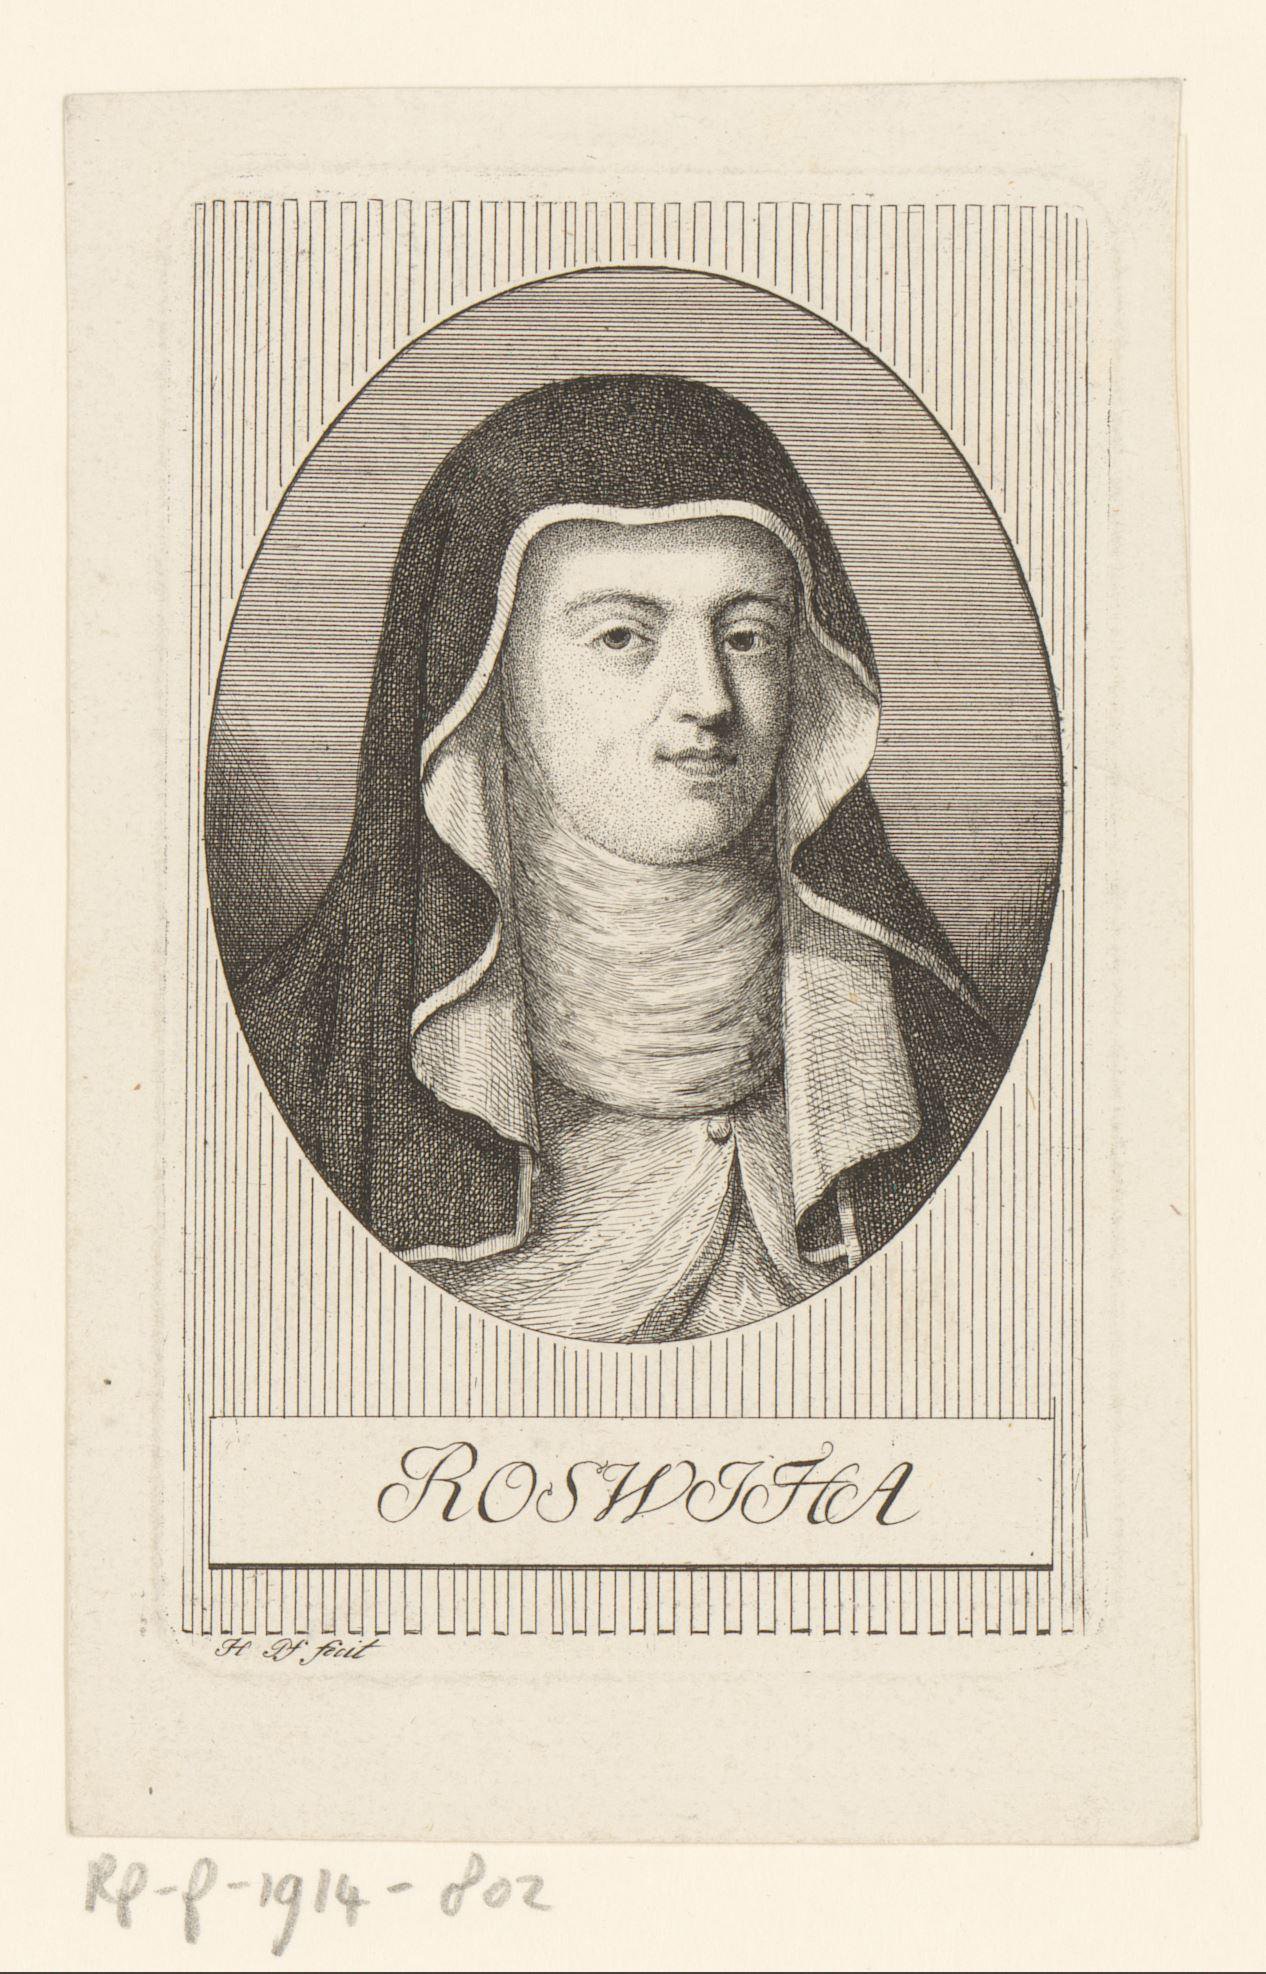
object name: print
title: Portret van Roswitha van Gandersheim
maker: heinrich pfenninger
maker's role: print maker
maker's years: 1749-1815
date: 1759-1815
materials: paper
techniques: etching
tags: historical persons - bb - woman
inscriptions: collector's mark: Lugt 2228